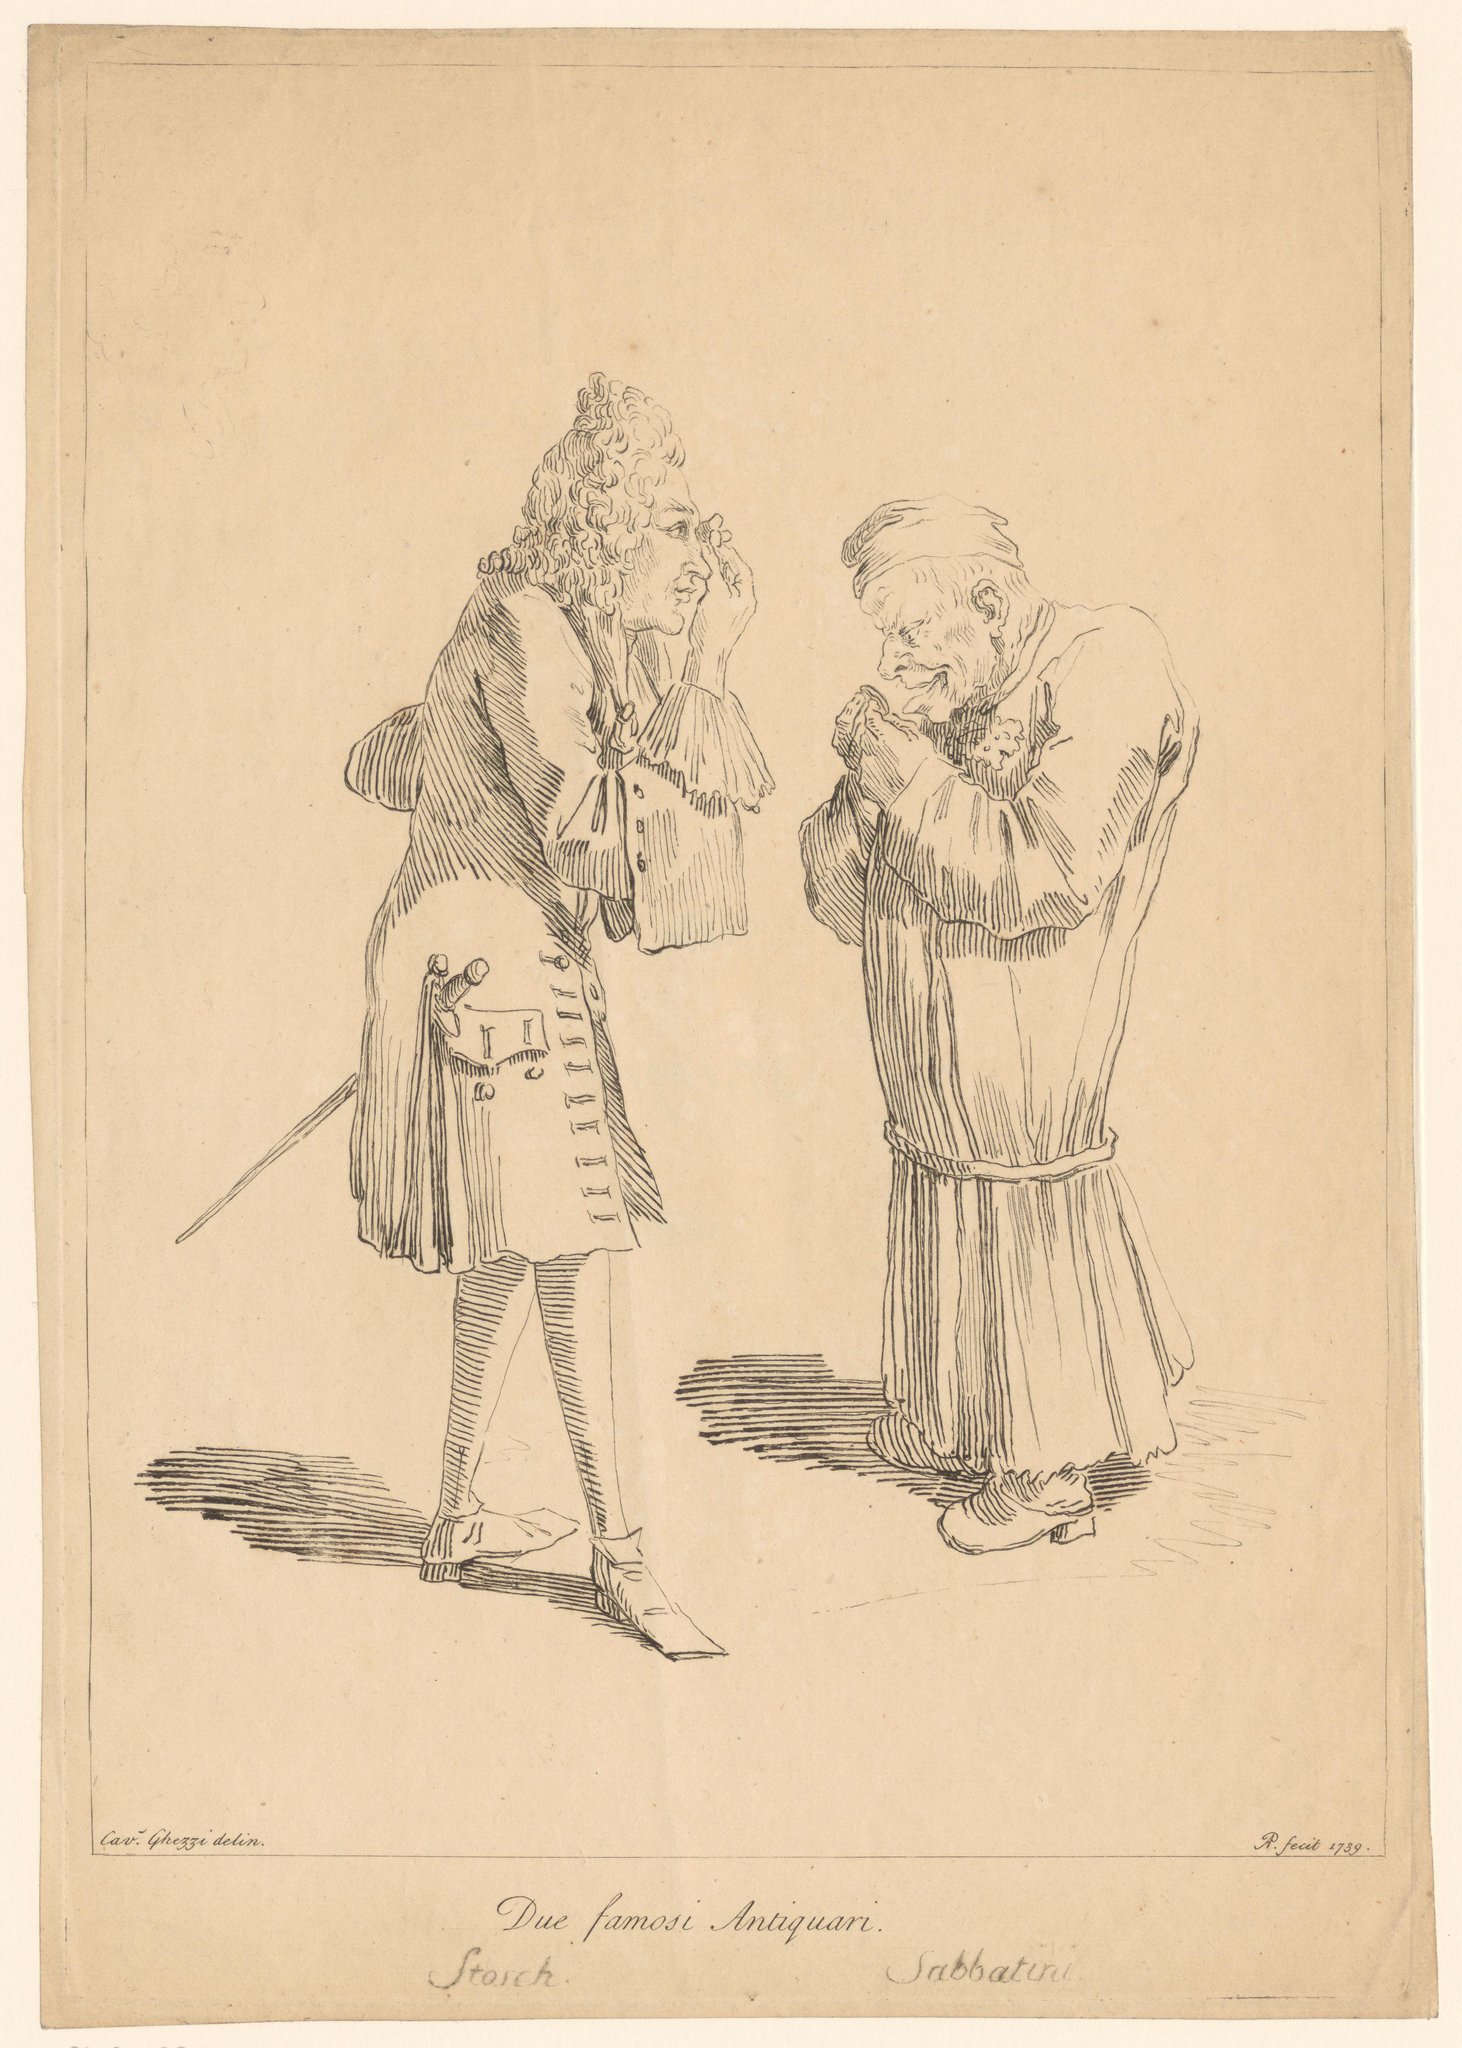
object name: cartoon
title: Karikatuur van Baron Philipp von Stosch en Marcantonio Sabatini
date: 1739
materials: paper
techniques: etching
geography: great britain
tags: caricatures (human types), historical persons, gem, gemstone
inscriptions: collector's mark: Lugt 2228